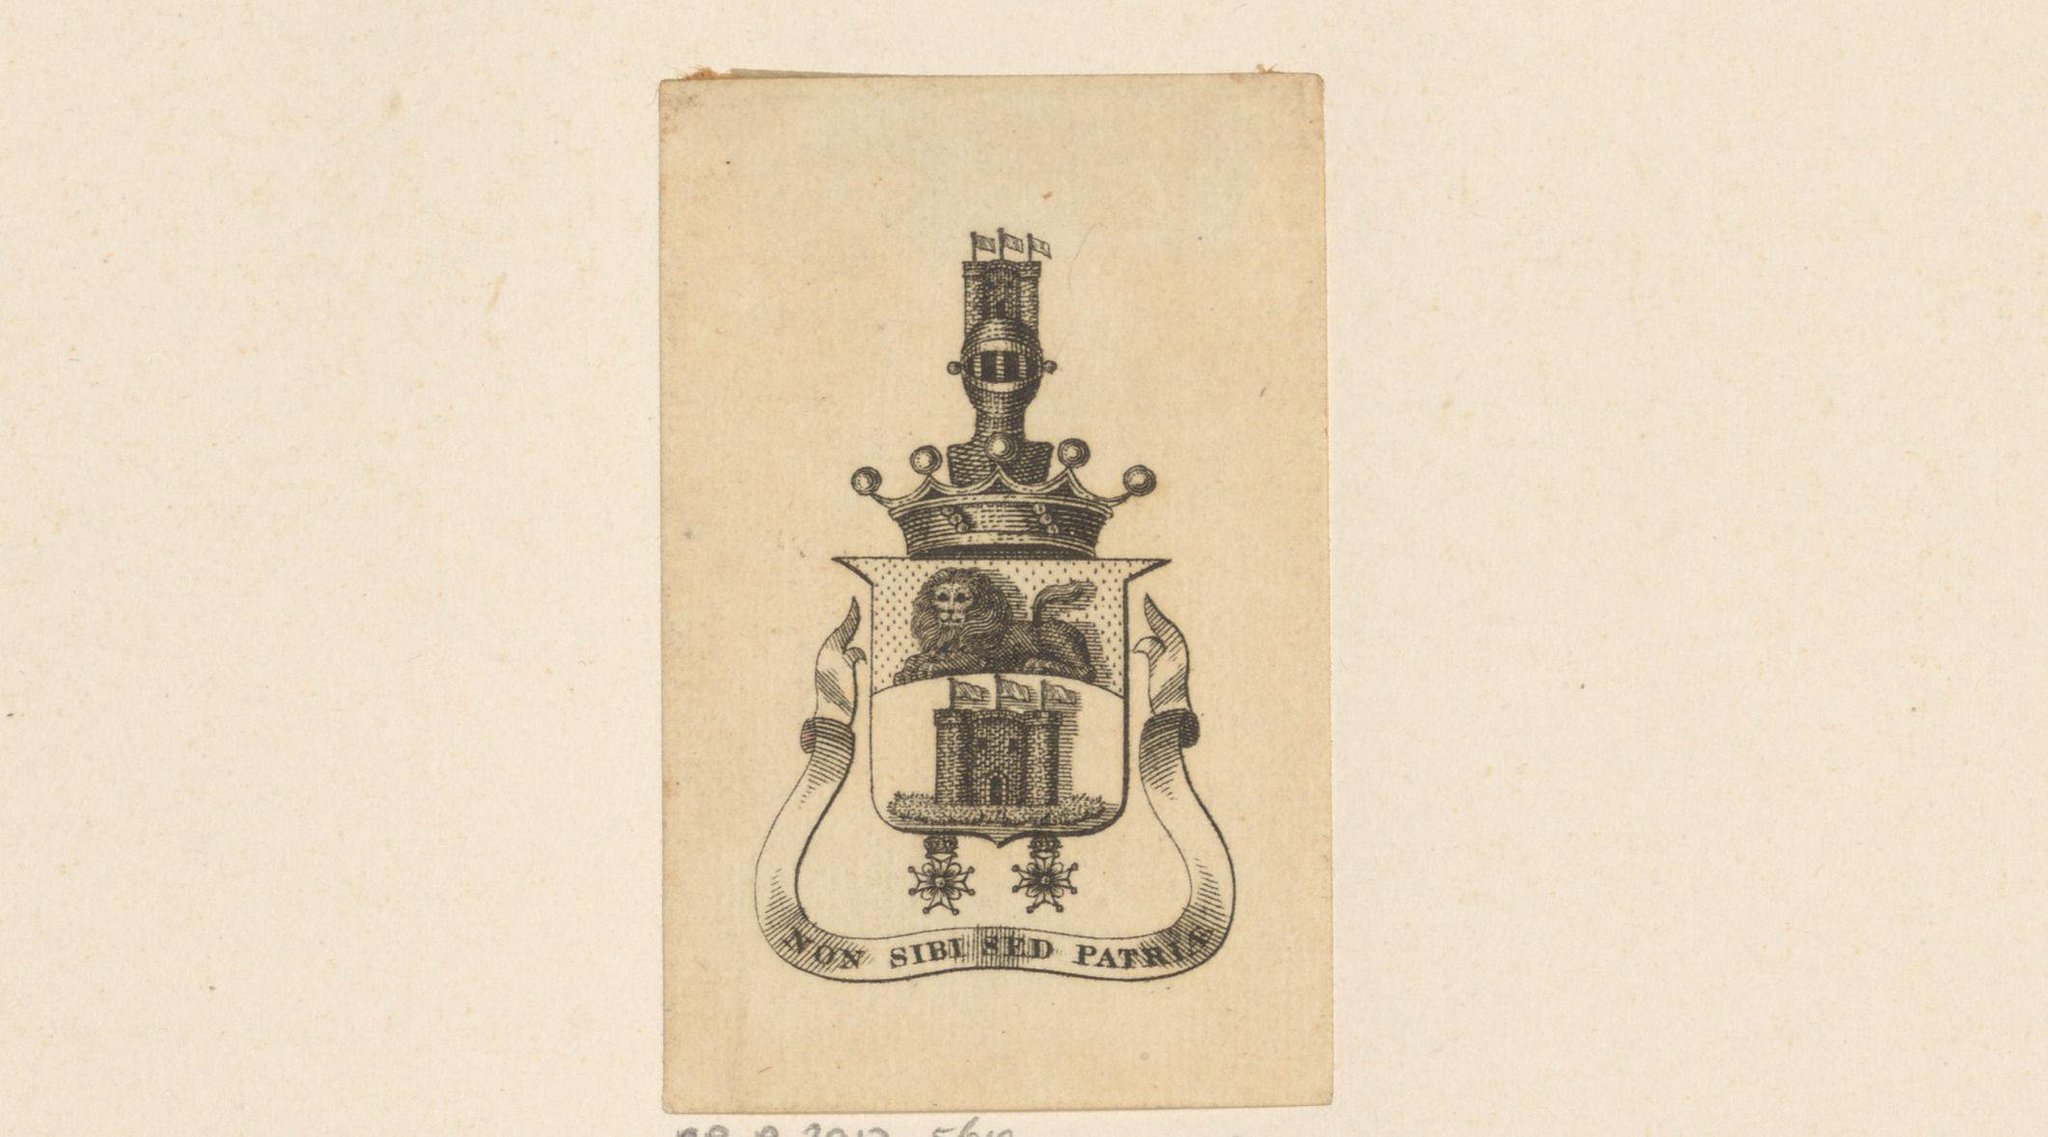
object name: bookplate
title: Ex libris van onbekend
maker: Anonymous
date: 1800-1899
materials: paper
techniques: etching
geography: england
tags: beasts of prey, predatory animals: lion, armorial bearing, heraldry